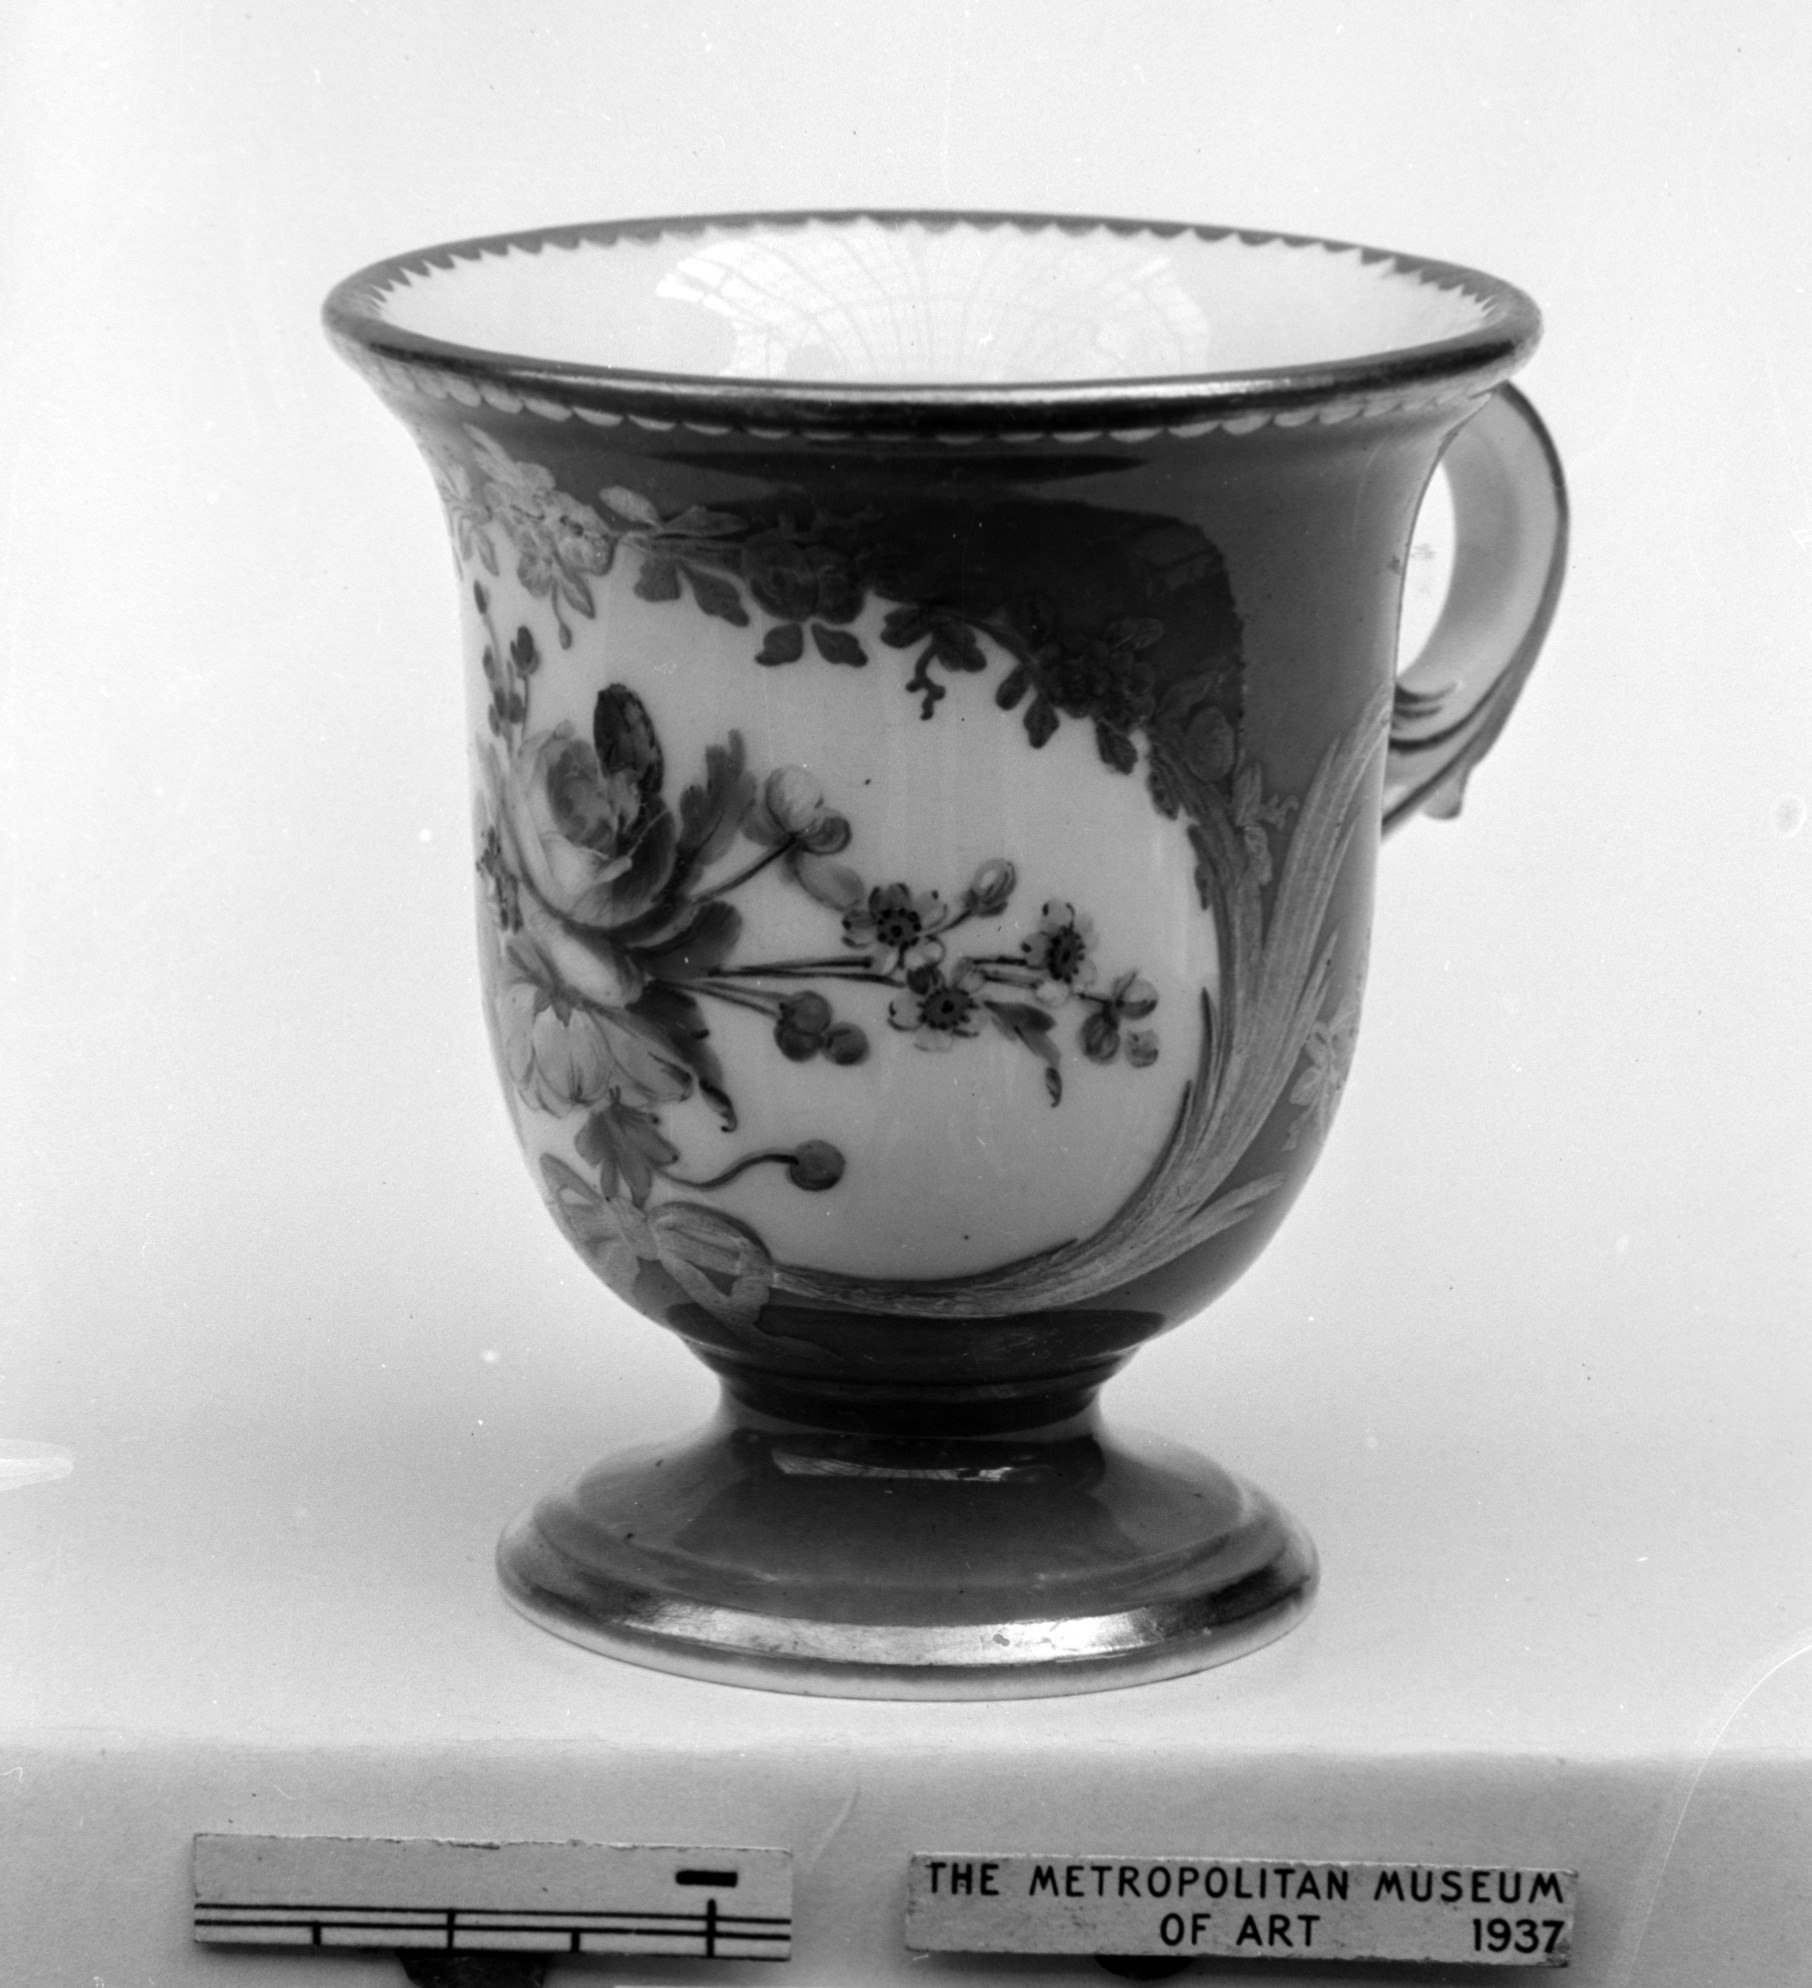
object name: ice cream cup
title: Ice cream cup (Tasse à glace) (part of a service)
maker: sèvres manufactory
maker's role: manufactory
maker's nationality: french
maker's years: 1740-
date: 1780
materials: soft paste porcelain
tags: flowers